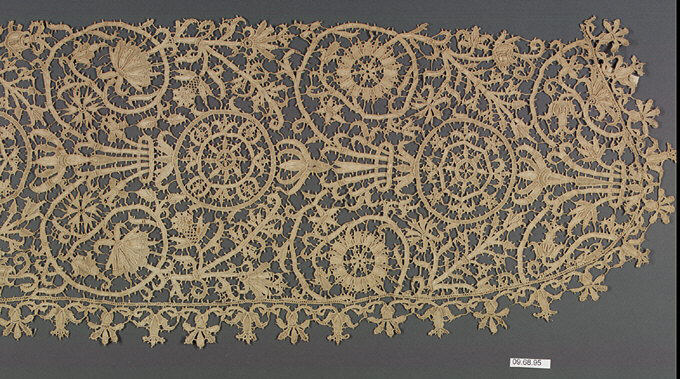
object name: border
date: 1501-1700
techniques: lace